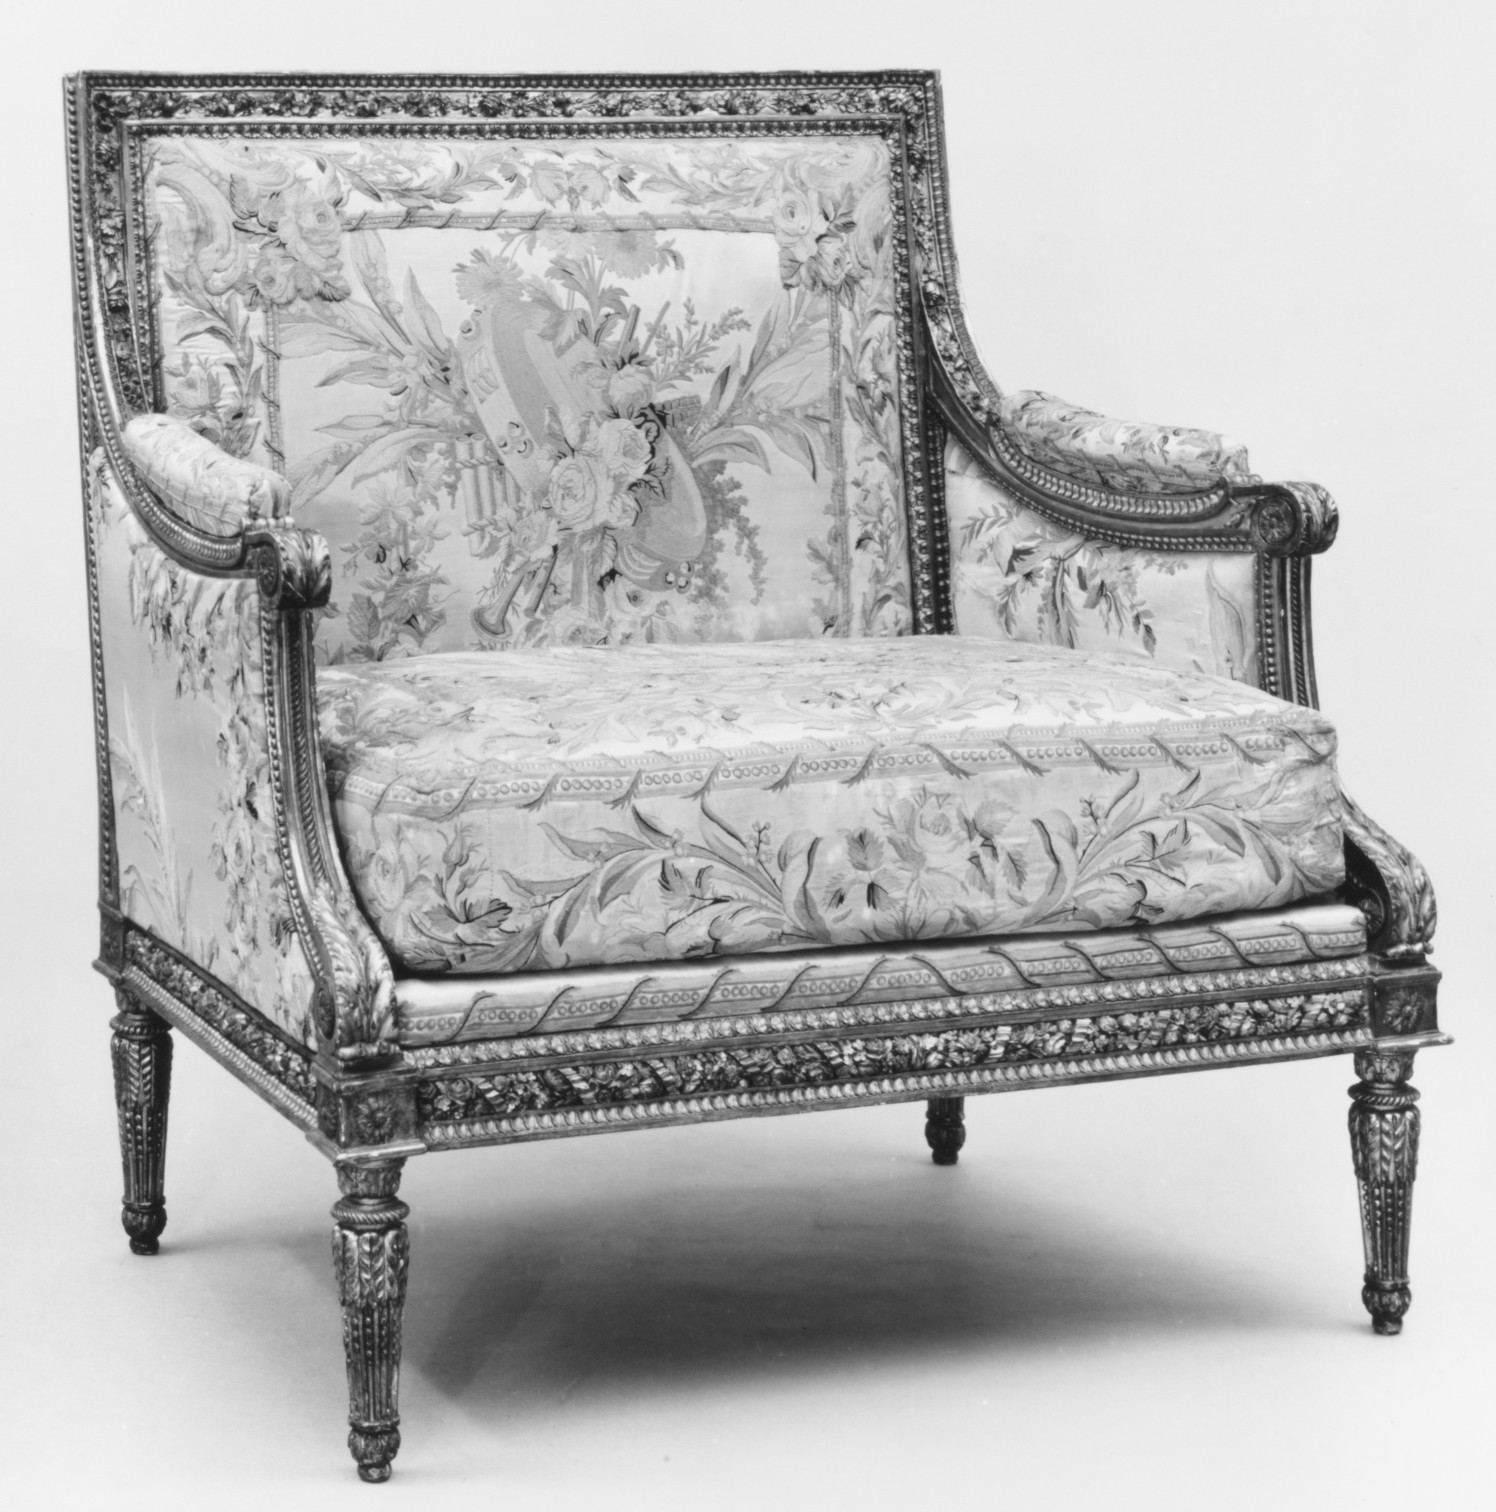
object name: settee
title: Small settee (Marquise) (part of a set)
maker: georges jacob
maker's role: maker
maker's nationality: french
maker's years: 1739-1814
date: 1785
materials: silk, wood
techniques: carving, embroidery, gilding